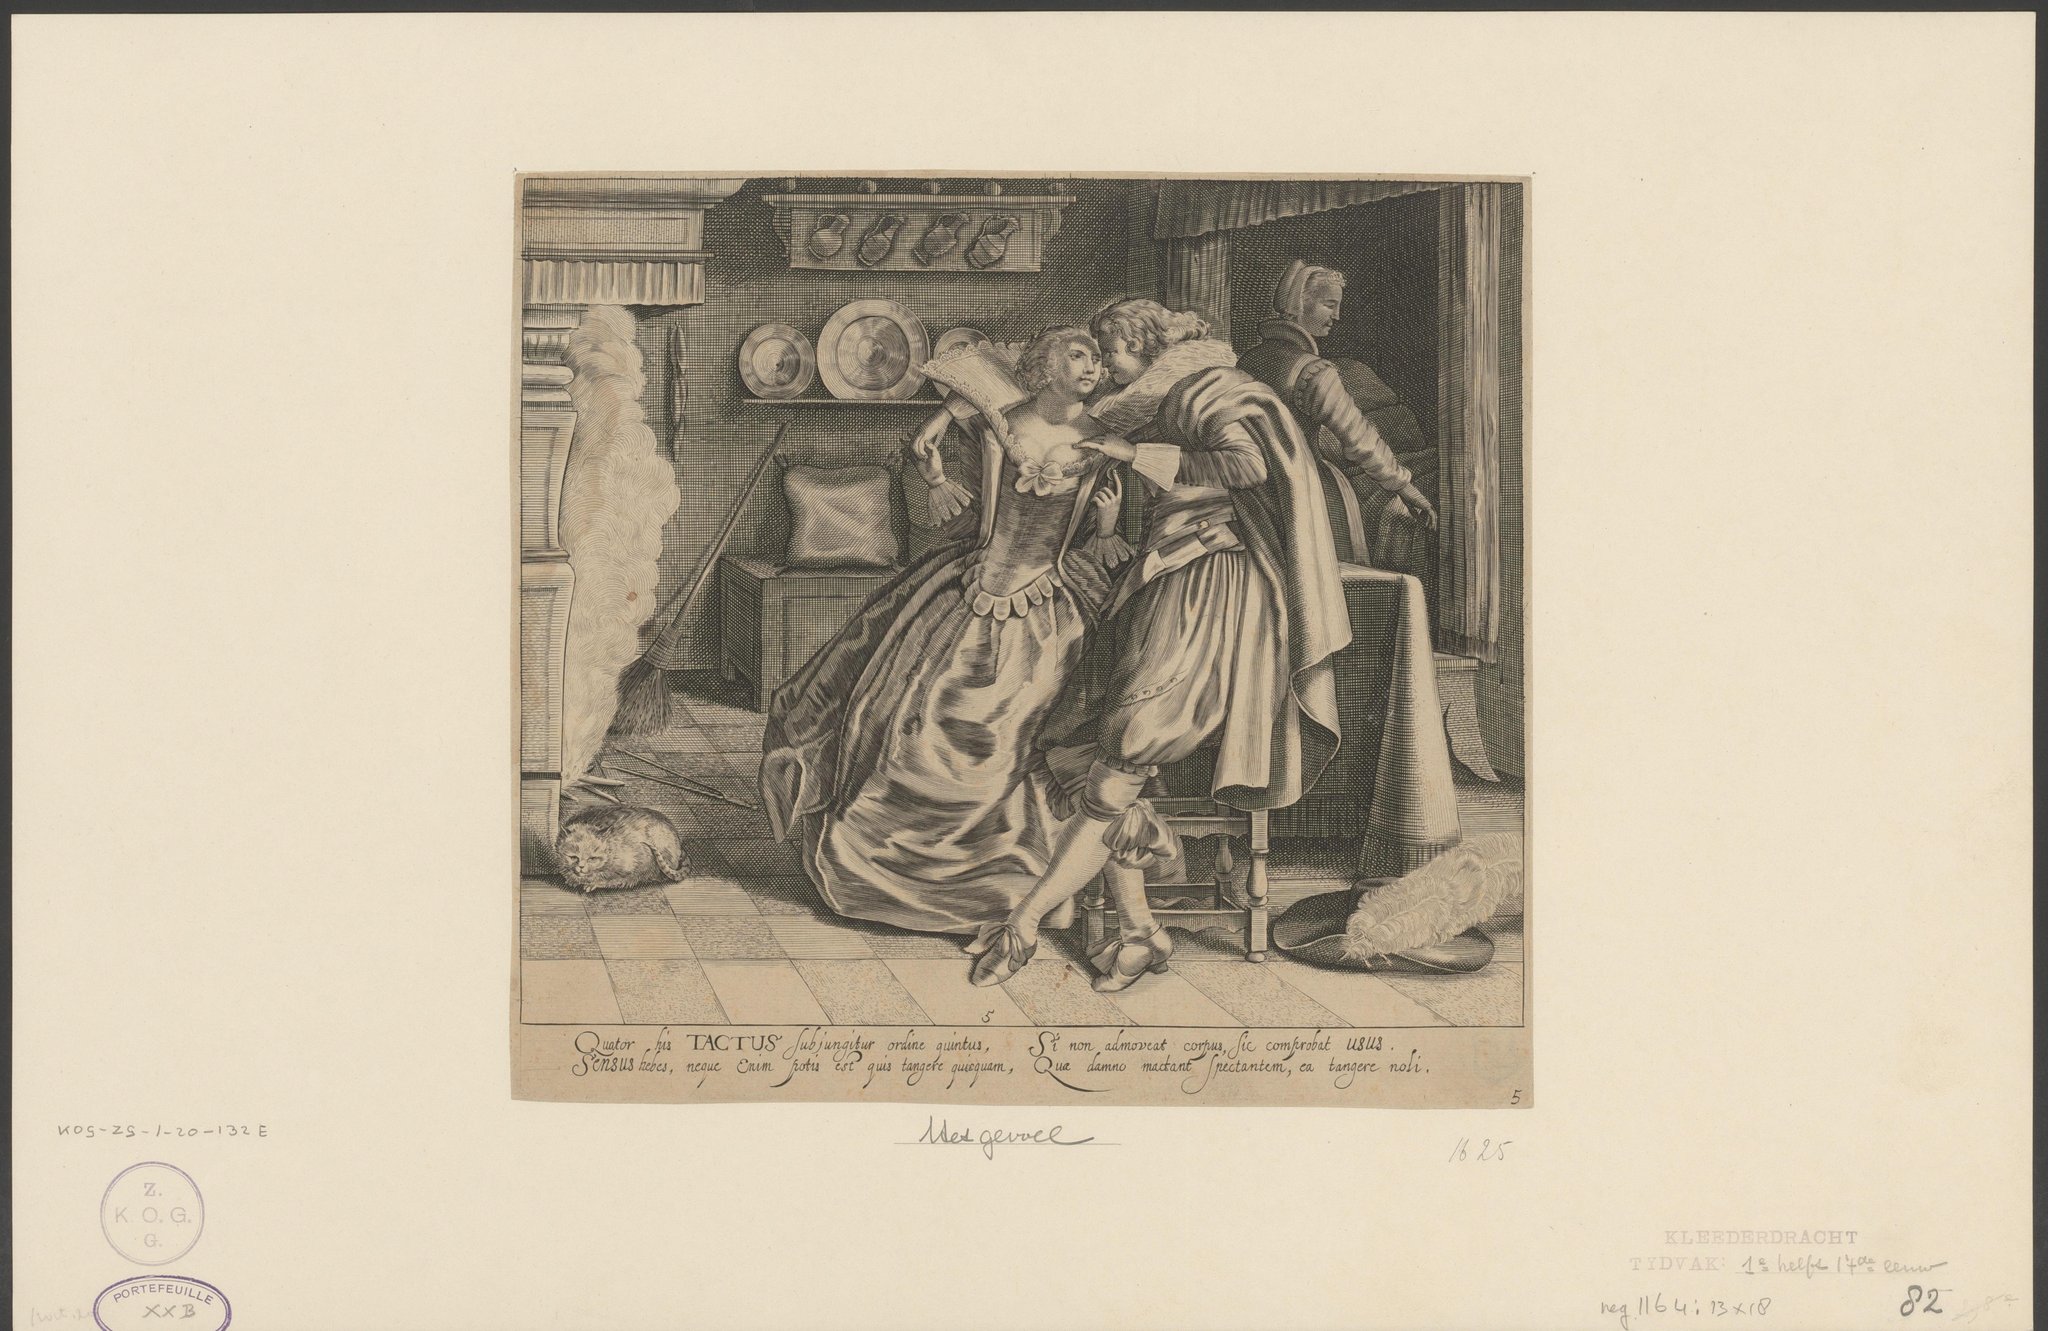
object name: print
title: Zintuig gevoel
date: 1620-1652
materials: paper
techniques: engraving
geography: amsterdam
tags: cat, clothes, costume (+ women's clothes), feeling (one of the five senses), clothes, costume (+ men's clothes), kitchen-interior, (lovers) caressing each other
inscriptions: stamp, collector's mark: Lugt 963, collector's mark: Lugt 1641, stamp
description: In een vertrek zit een minnend paar bij het haardvuur, gekleed in de mode van ca. 1620. De man heeft zijn rechterarm om de schouders van de dame gelegd en raakt met zijn linkerhand een van haar borsten aan, terwijl de dame hem aankijkt. Zij draagt een japon met decolleté en een grote opstaande kanten kraag. Bij de haard zit een kat en rechtsachter wordt de bedstee opgemaakt door een bediende. Onder de afbeelding een vierregelig vers in twee kolommen met Latijnse tekst. Onderaan en rechtsonder genummerd: 5. Onderwerpsrubrieken binnen de Atlas Zeden en Gewoonten: Zeden en Gewoonten in Engeren Zin, De Kleeding, Kleederdrachten (tijdvakken), Het begin der 17de eeuw. (De Fransche mode).